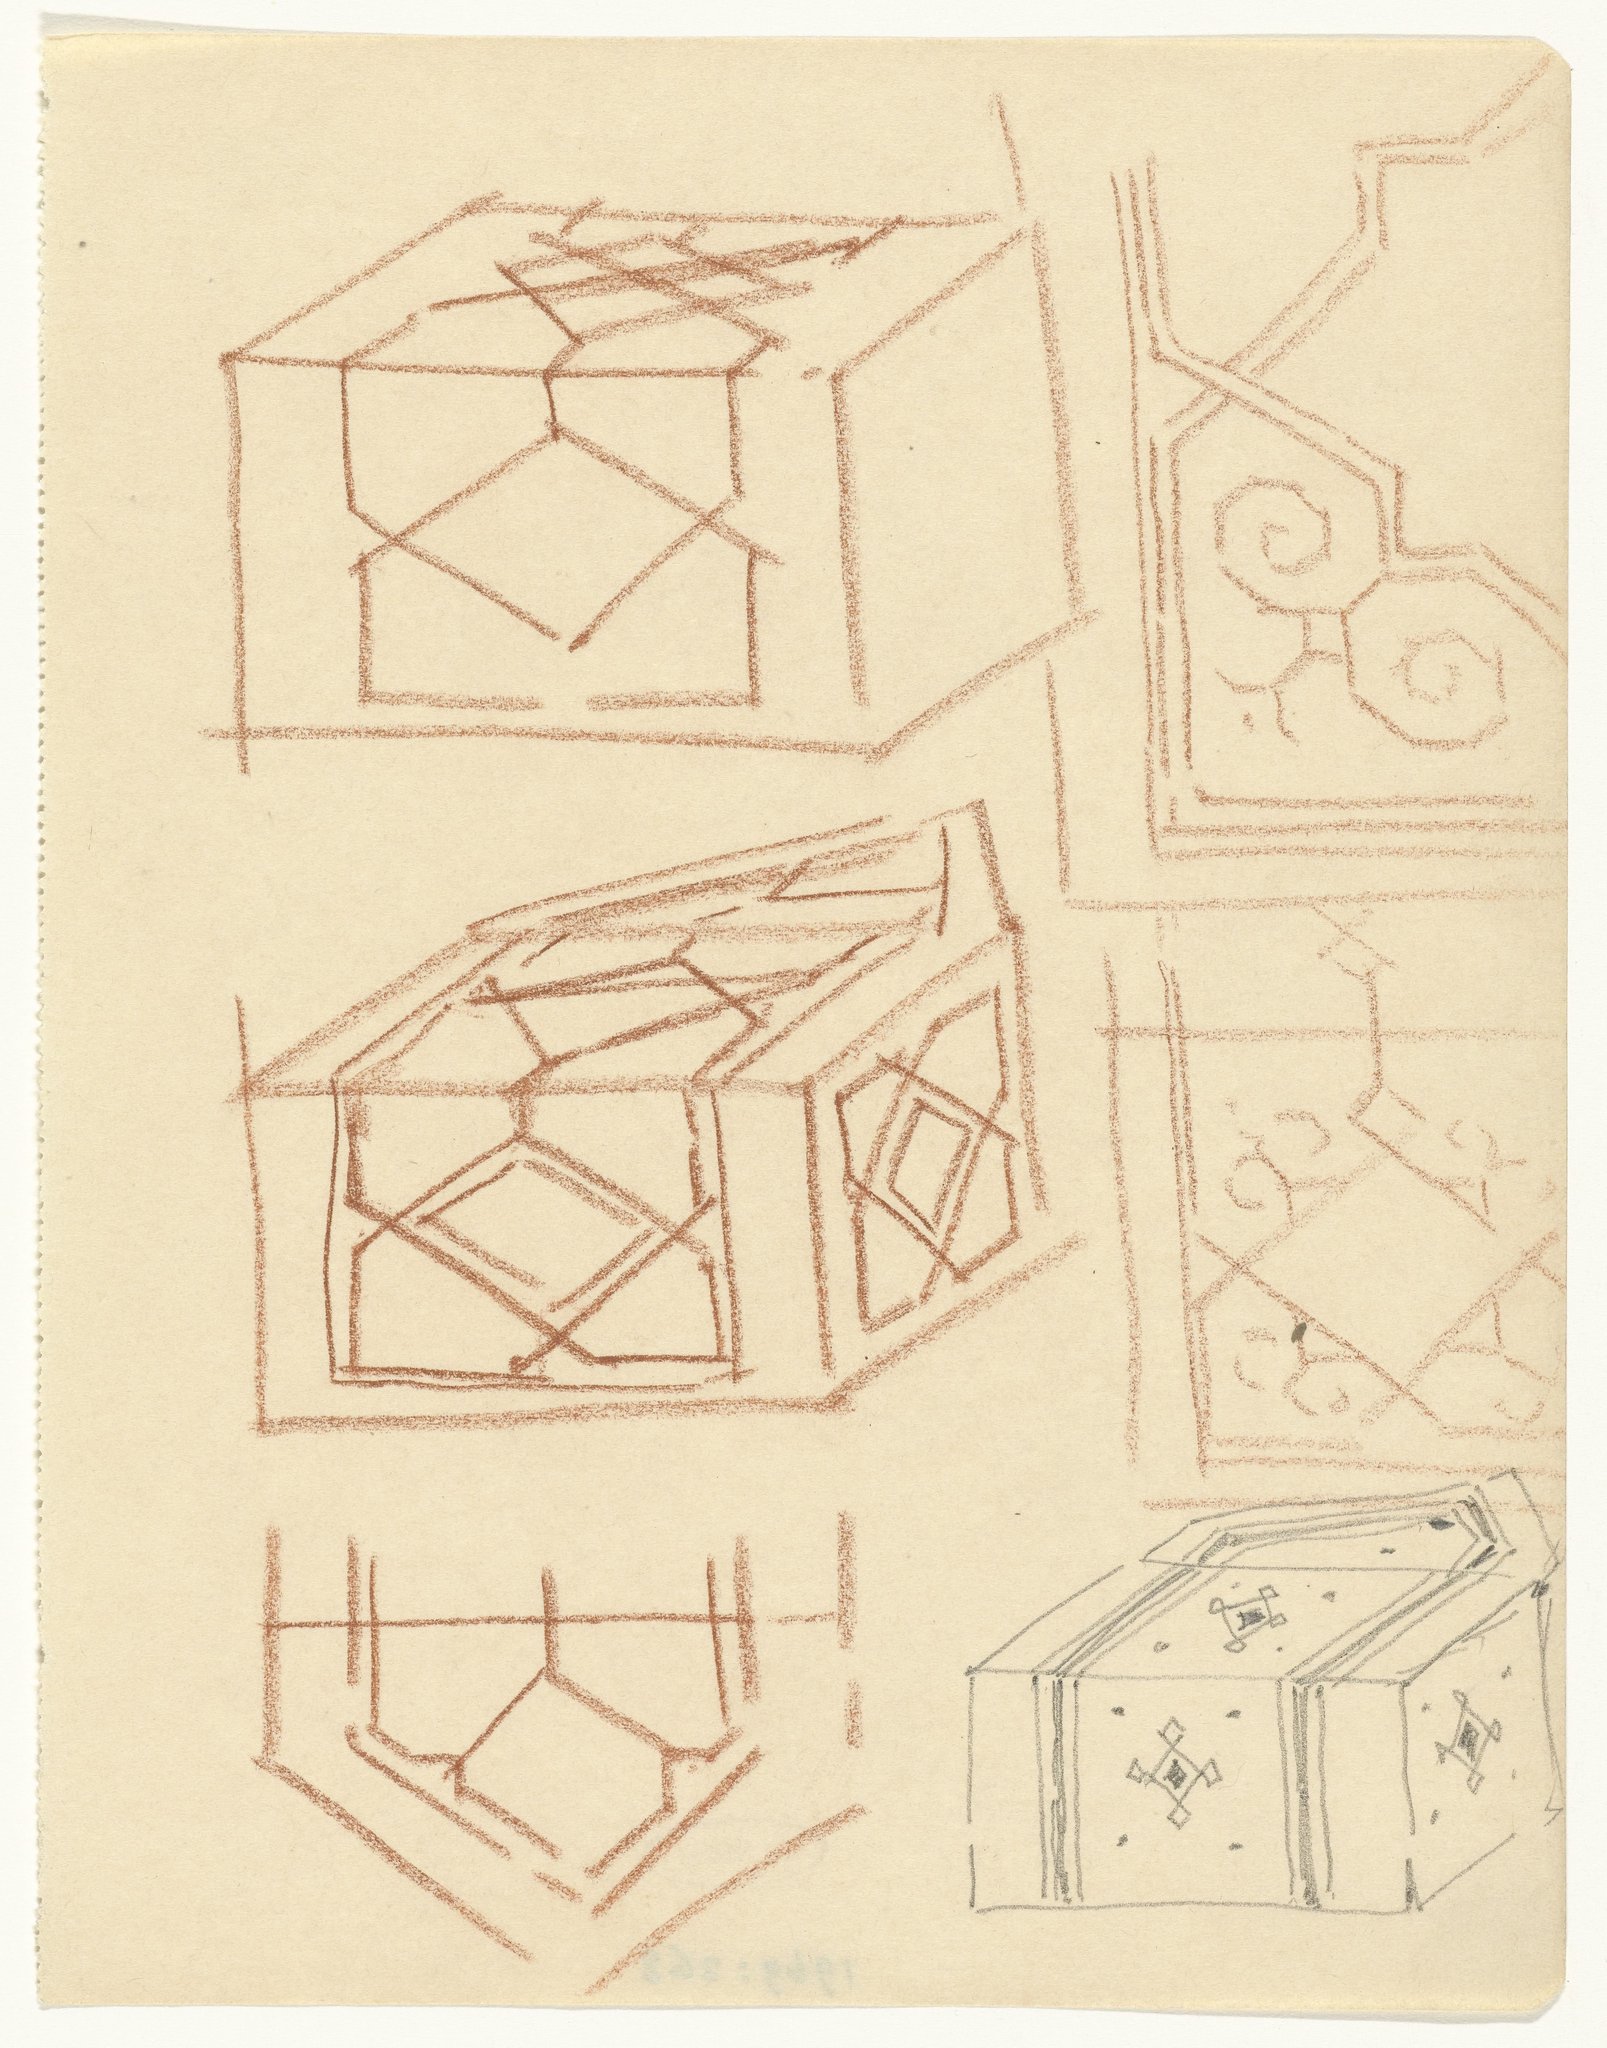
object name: drawing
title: Ornamentontwerpen op blokken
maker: gerrit willem dijsselhof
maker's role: designer, draughtsman, print maker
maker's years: 1866-1924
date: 1876-1924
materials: chalk, paper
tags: ornaments ~ art